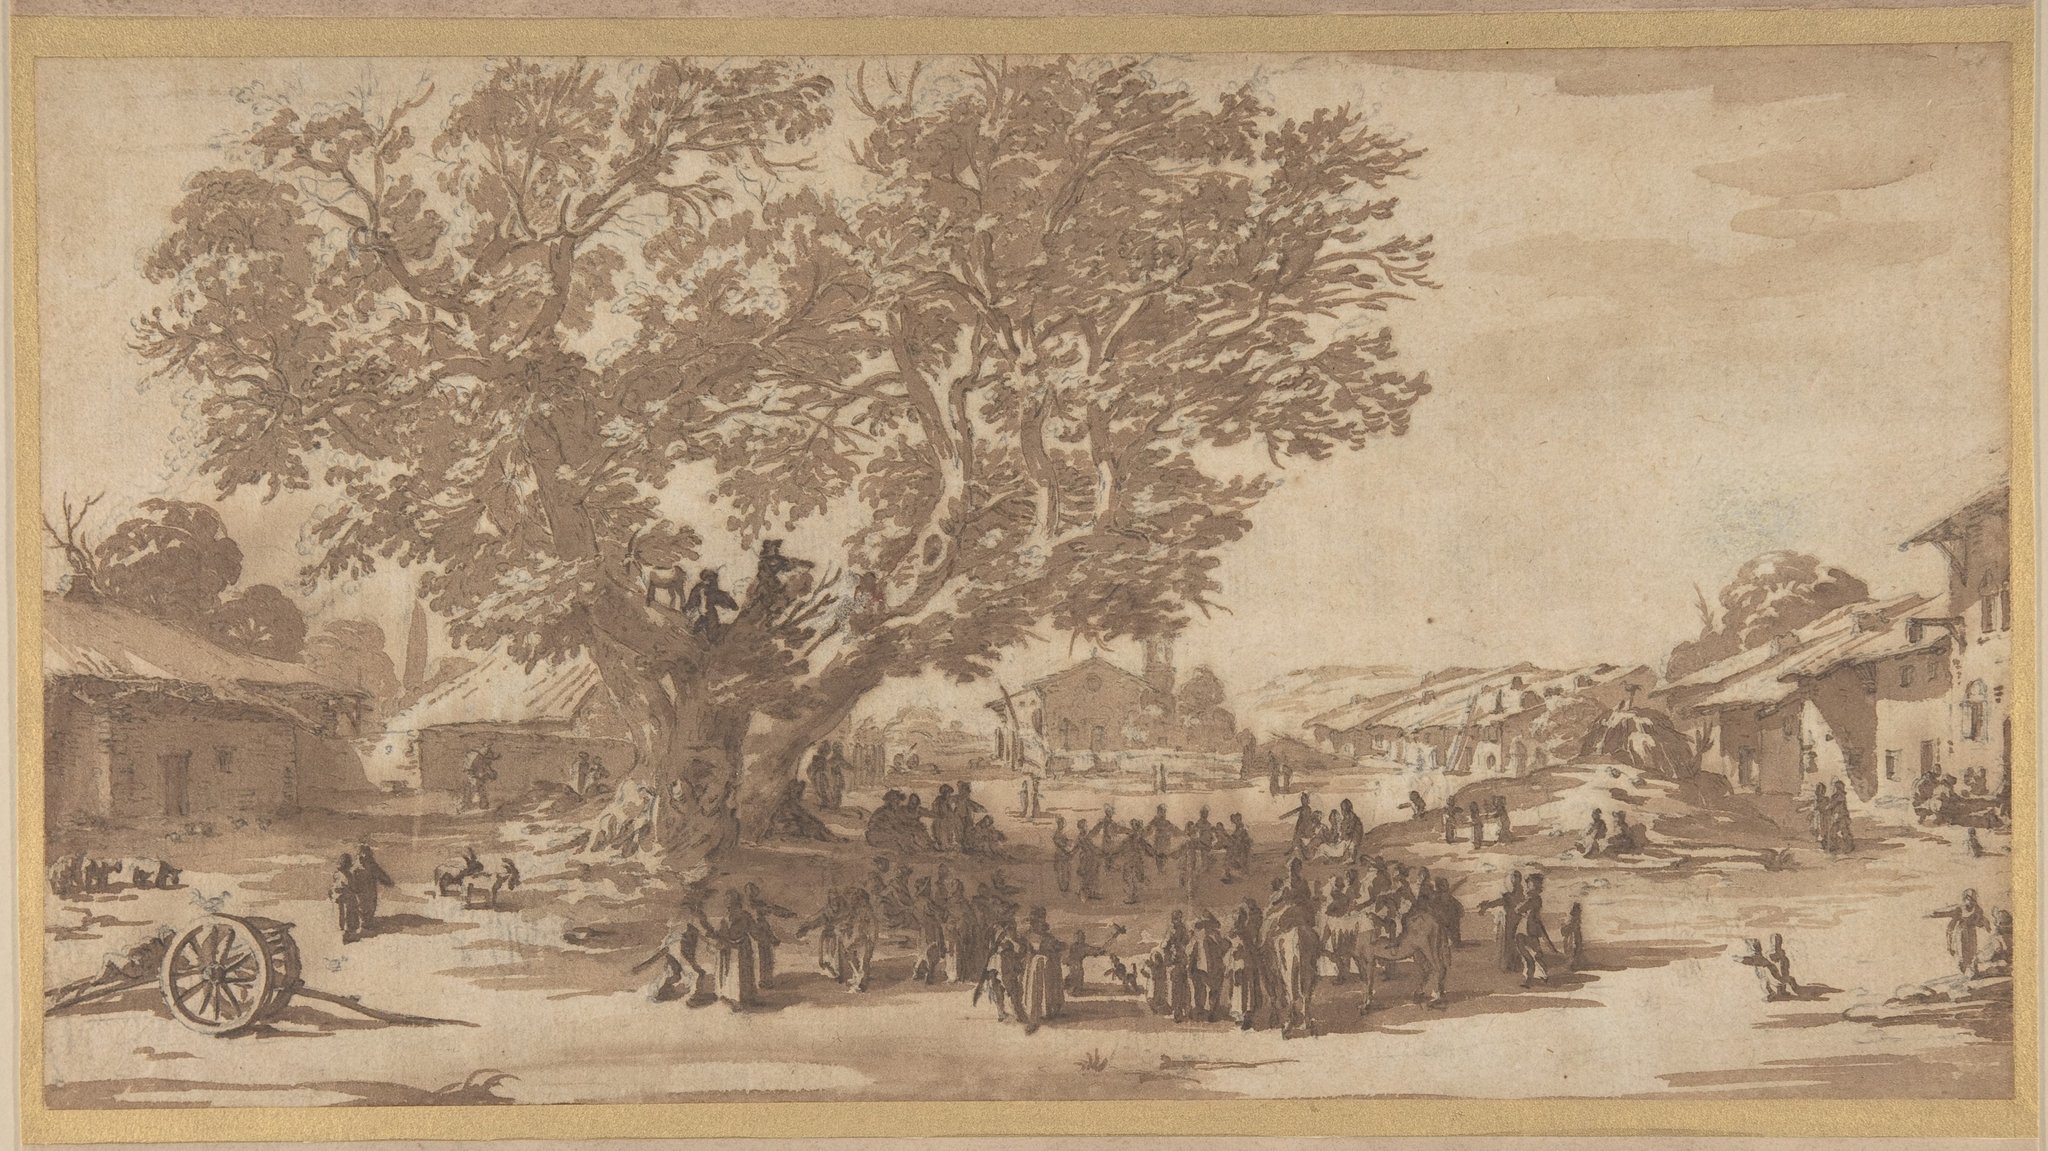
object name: drawing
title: May Day Celebrations at Xeuilley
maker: jacques callot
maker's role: artist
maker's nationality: french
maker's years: 1592-1635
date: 1624-1625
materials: ink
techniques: brush, pen, wash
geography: france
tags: human figures,villages,dancing,trees